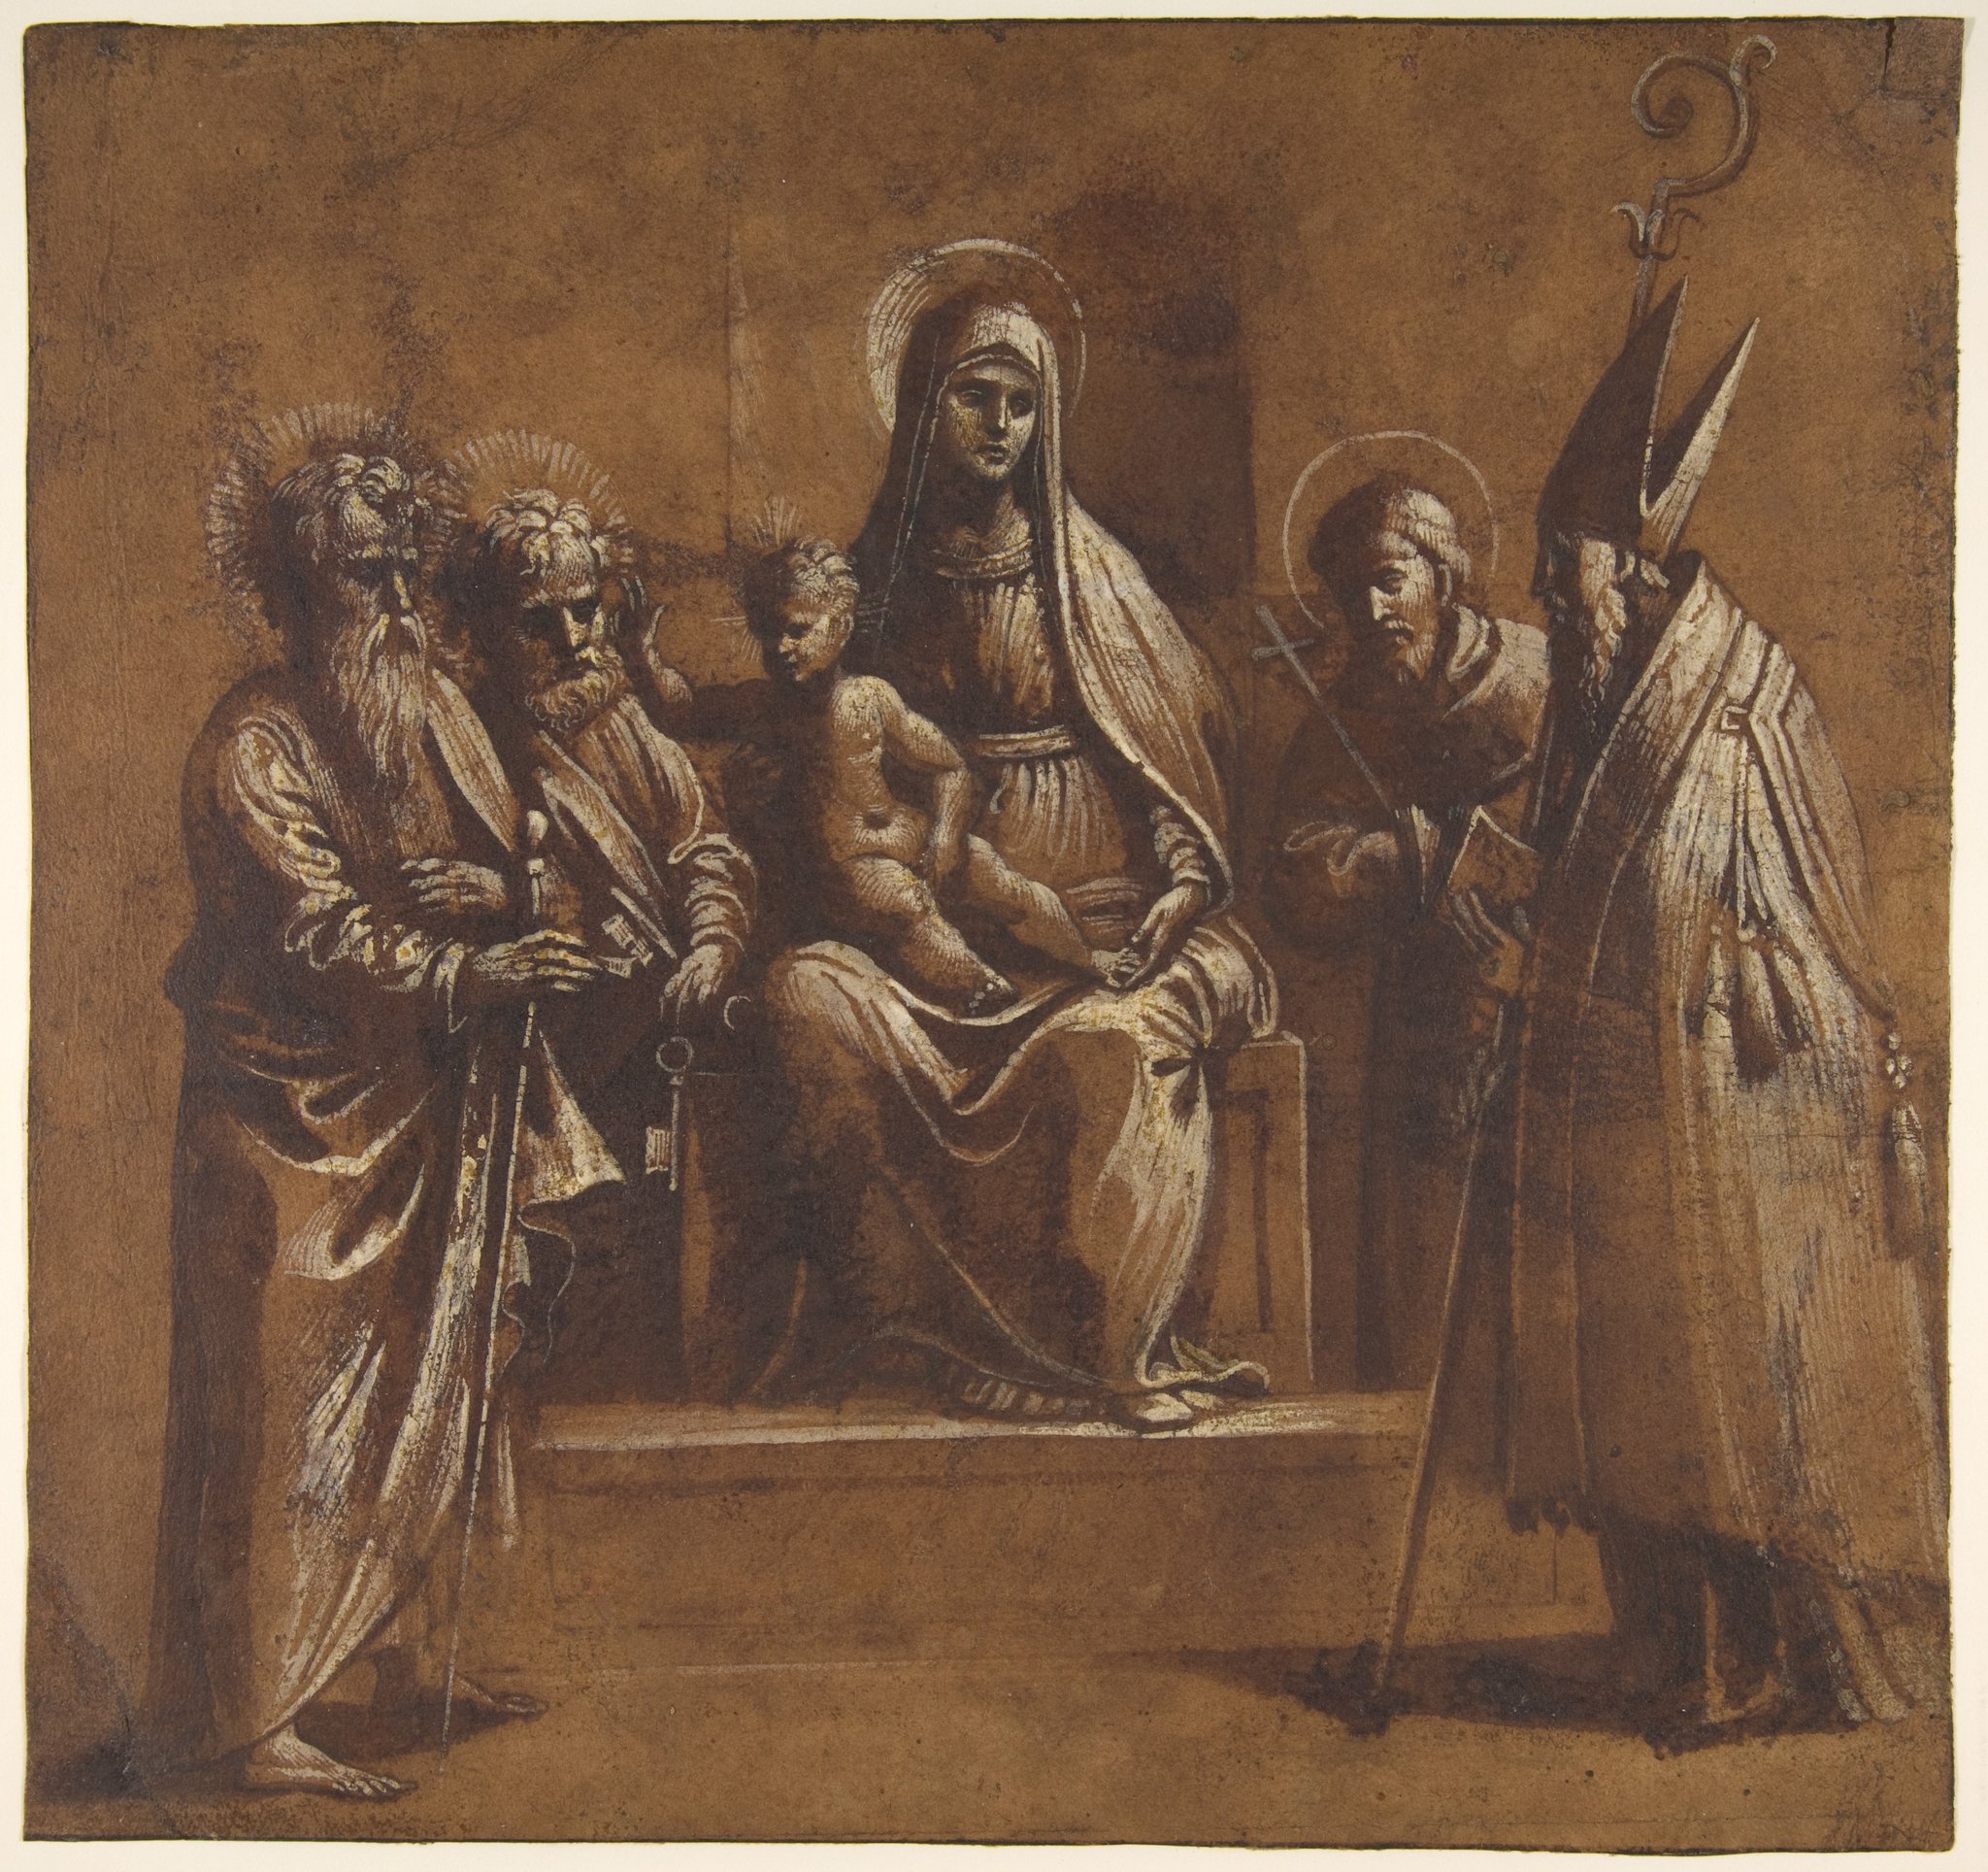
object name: drawing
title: The Virgin and Child with Saints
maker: girolamo da treviso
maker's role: artist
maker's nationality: italian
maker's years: 1498-1544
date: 1498-1544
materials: gouache, ink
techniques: brush, highlighting, pen, wash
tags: men,virgin mary,saints